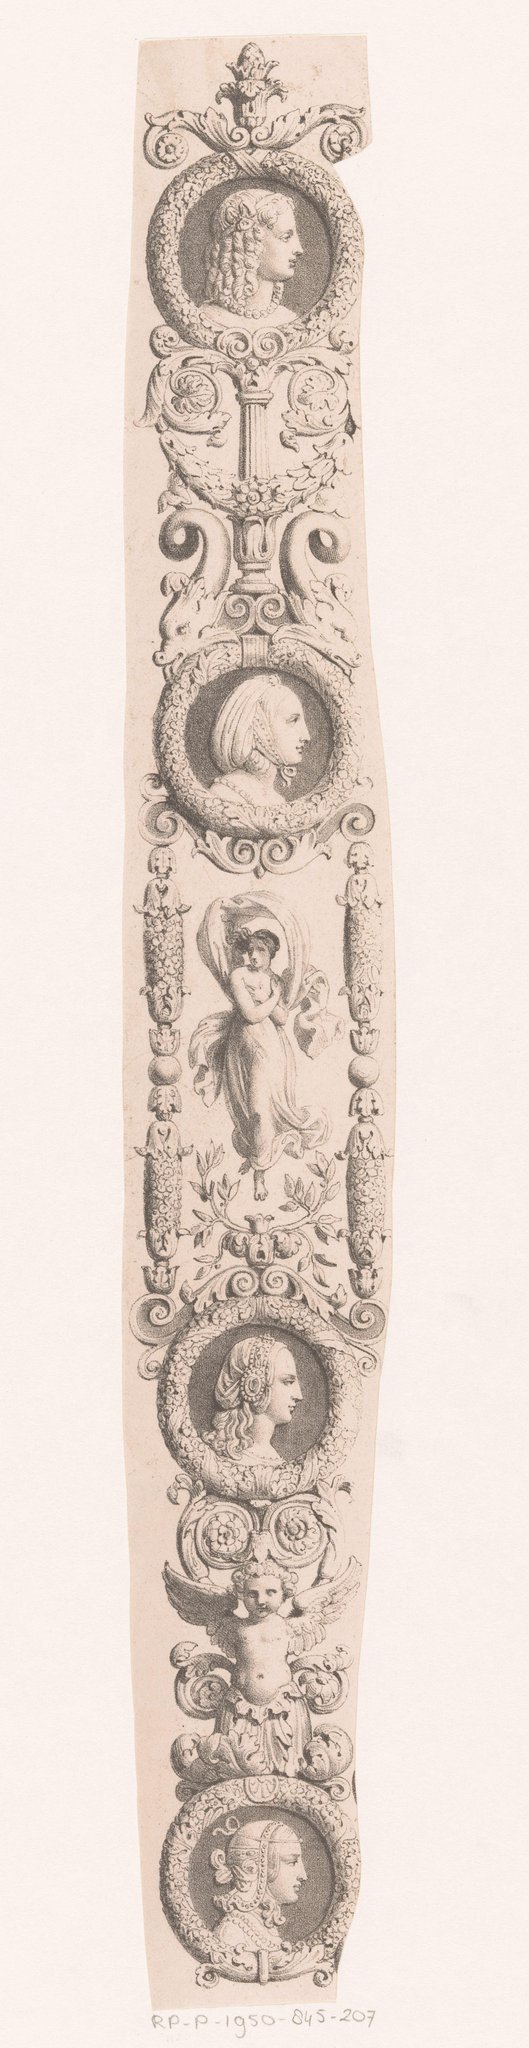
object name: ornament print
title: Ornament met medaillons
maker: Anonymous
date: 1700-1800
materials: paper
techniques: printmaking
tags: ornaments ~ art, ornament ~ medallion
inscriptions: collector's mark: Lugt 2228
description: Prent afkomstig uit een plakalbum met titelprenten, ornamenten etc. op blauw papier in 1983 uit elkaar gehaald. Volgens een notitie op verso zat de prent op p. 207 van dit album.